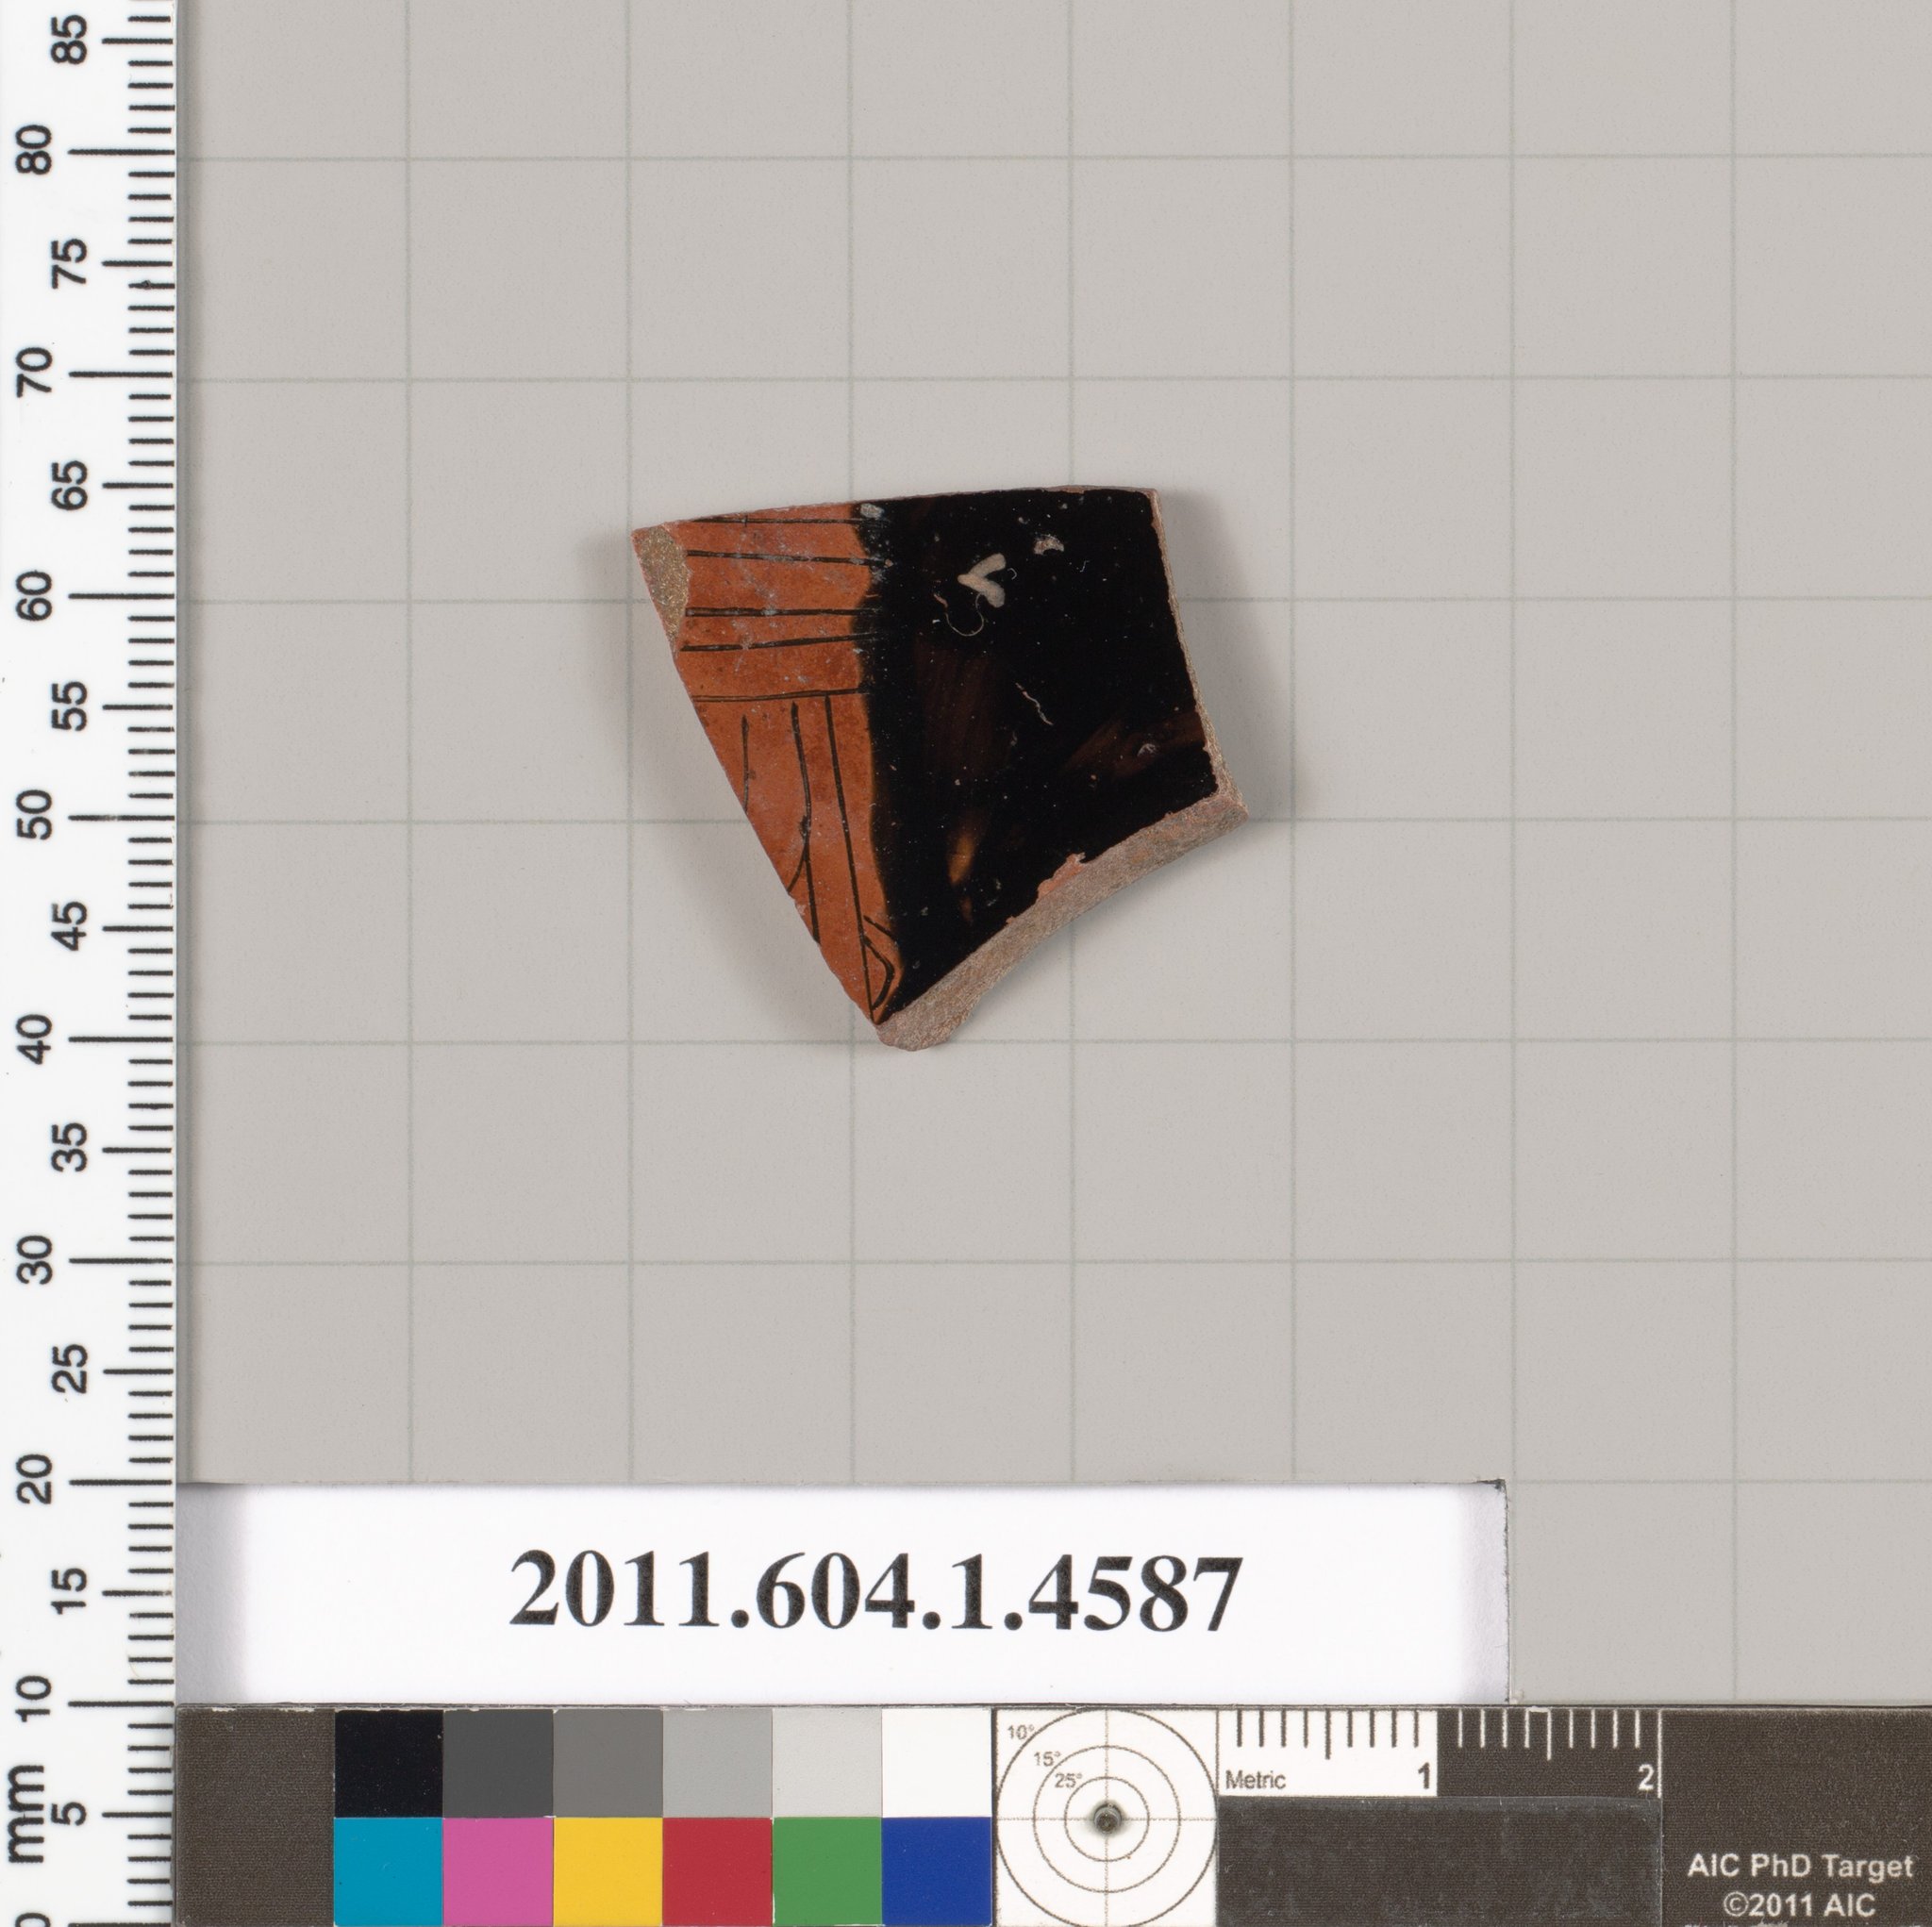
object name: kylix fragment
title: Terracotta fragment of a kylix (drinking cup)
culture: greek, attic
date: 500-480 BCE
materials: terracotta